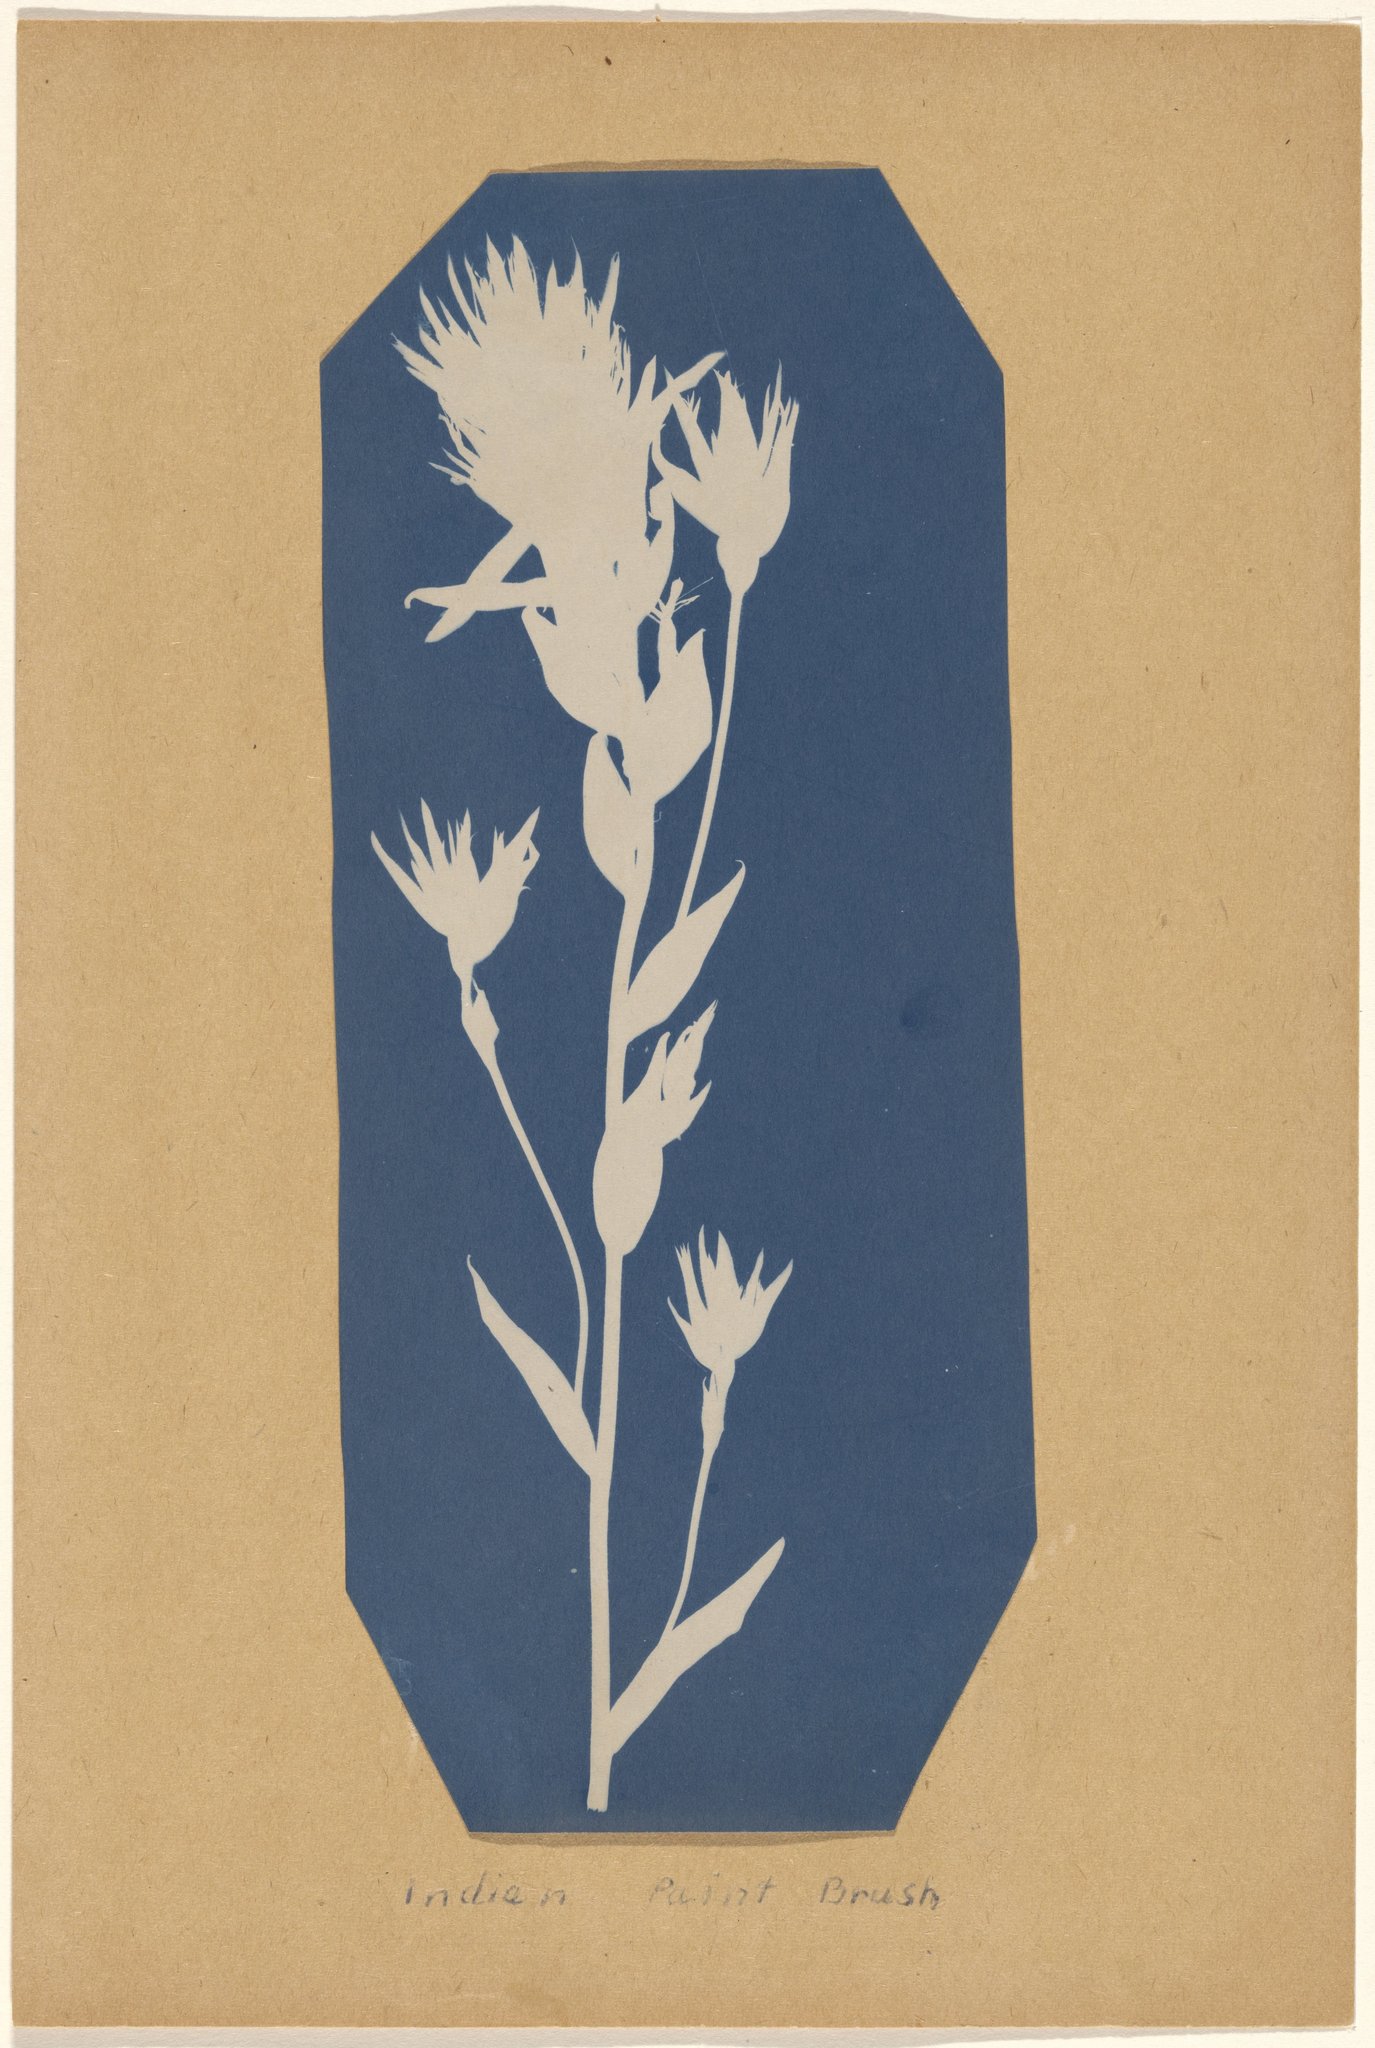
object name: photogram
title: Indian paintbrush (Castilleja mutis)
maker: bertha e. jaques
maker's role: fotograaf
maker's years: 1863-1941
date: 1900-1910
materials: cardboard, paper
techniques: cyanotype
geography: united states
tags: flowers: indian paintbrush